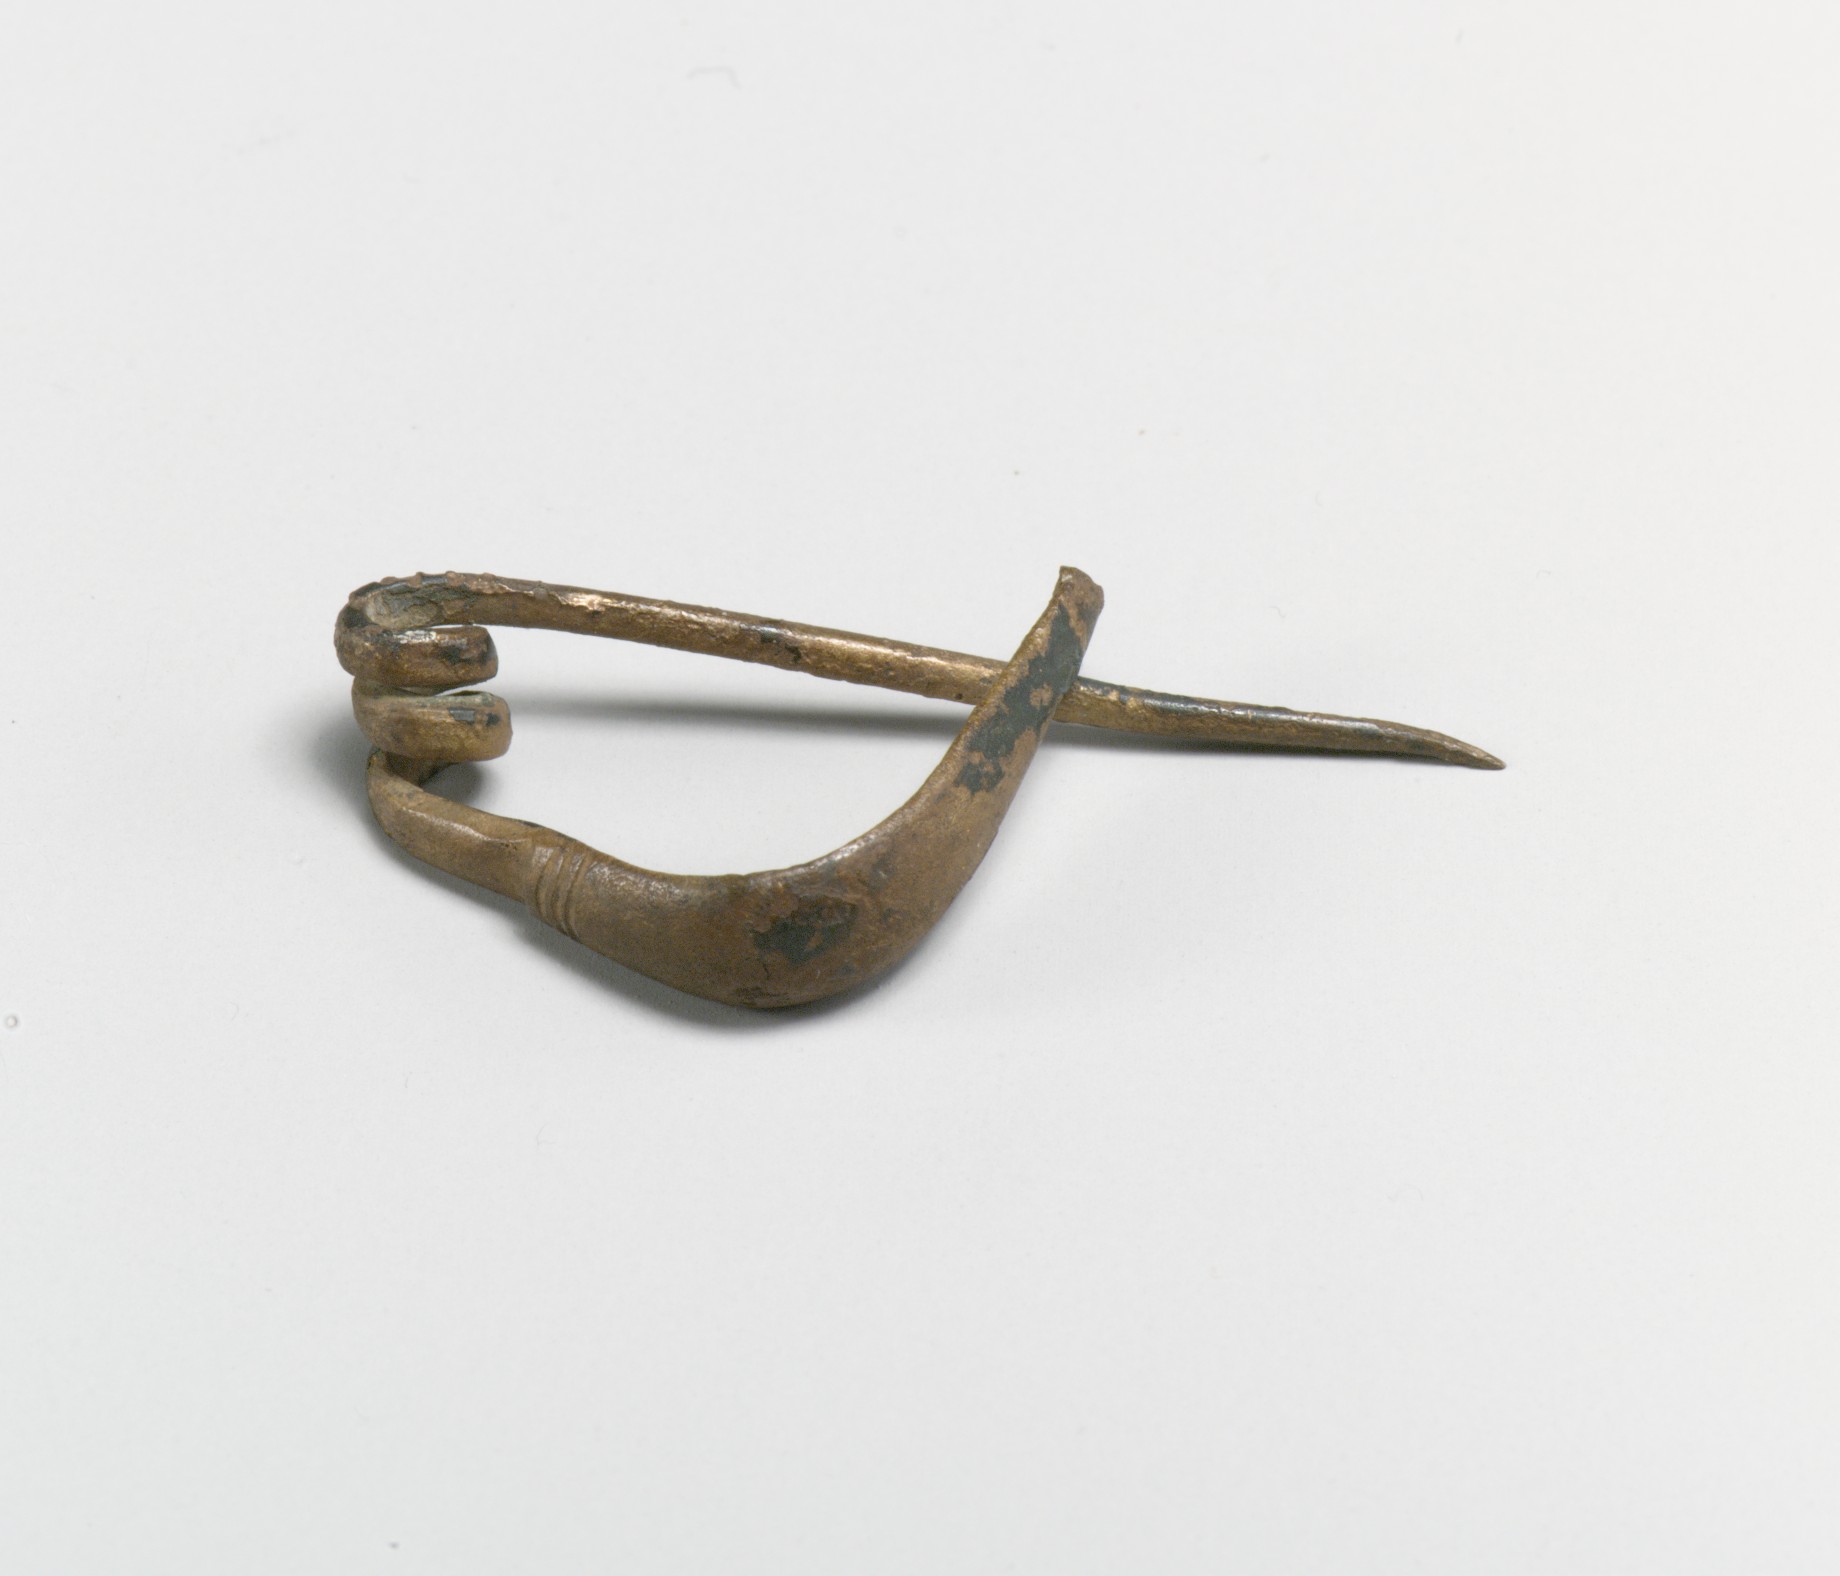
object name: fibula, boat shaped type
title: Fibula, boat-shaped type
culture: italic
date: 800-501 BCE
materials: bronze